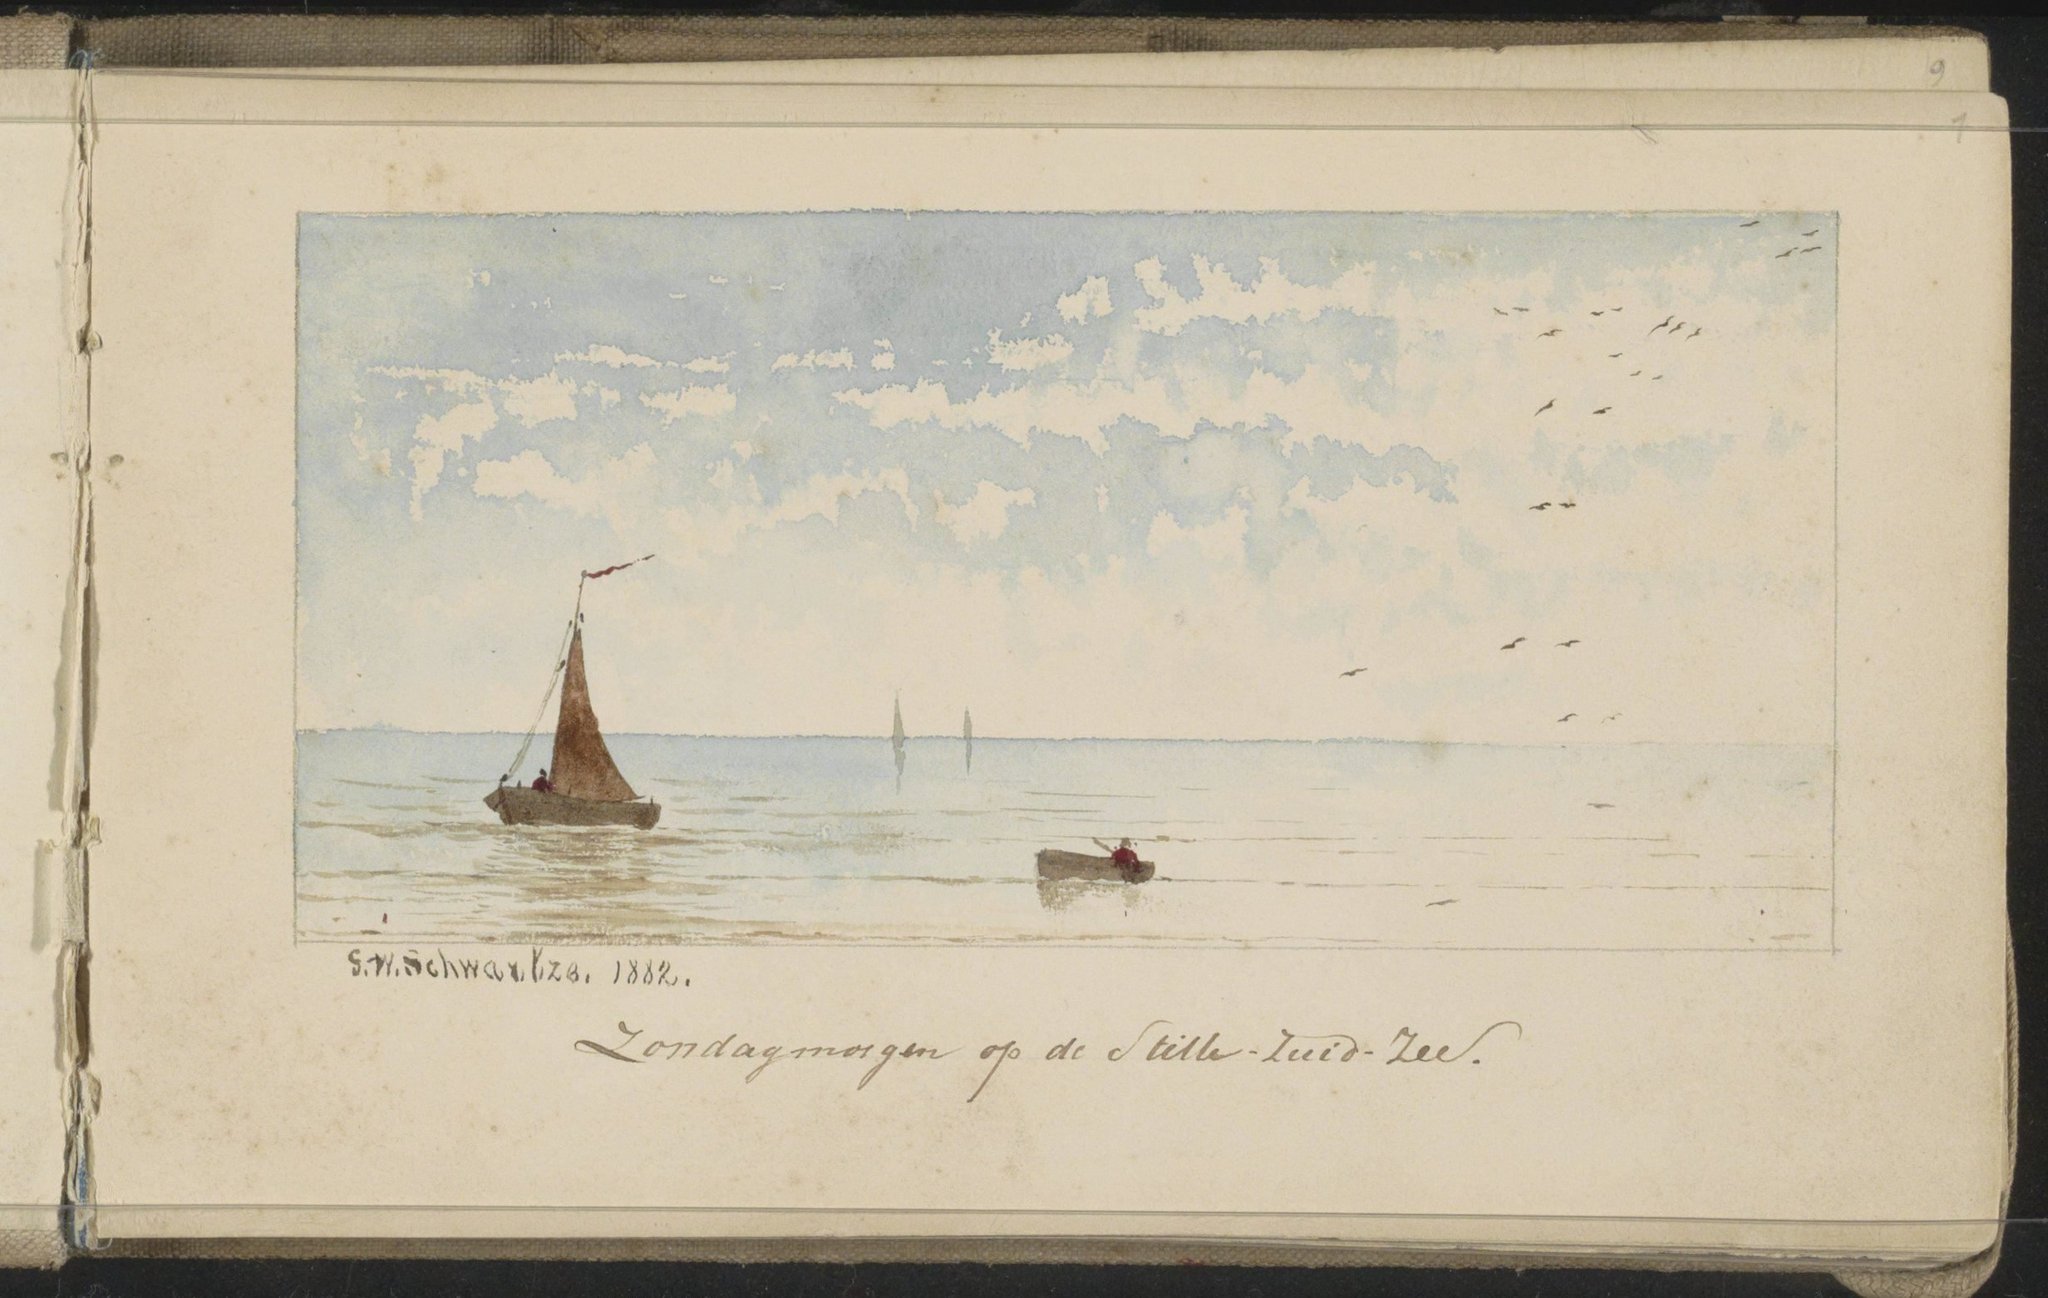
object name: sketchbook leaf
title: Zondagmorgen op de Stille Zuid-Zee.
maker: george washington schwartze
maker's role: draughtsman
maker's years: 1857-1909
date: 1882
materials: ink, paper, pencil, watercolor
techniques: brush, pen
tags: sailing-ship, sailing-boat, ocean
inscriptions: signature and date: ‘G.W.Schwartze. 1882.’, title: ‘Zondagmorgen op de Stille-Zuid-Zee.’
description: Zeegezicht met een roeiboot en zeilboten in een kader. Blad 1 recto uit een schetsboek met 54 bladen.